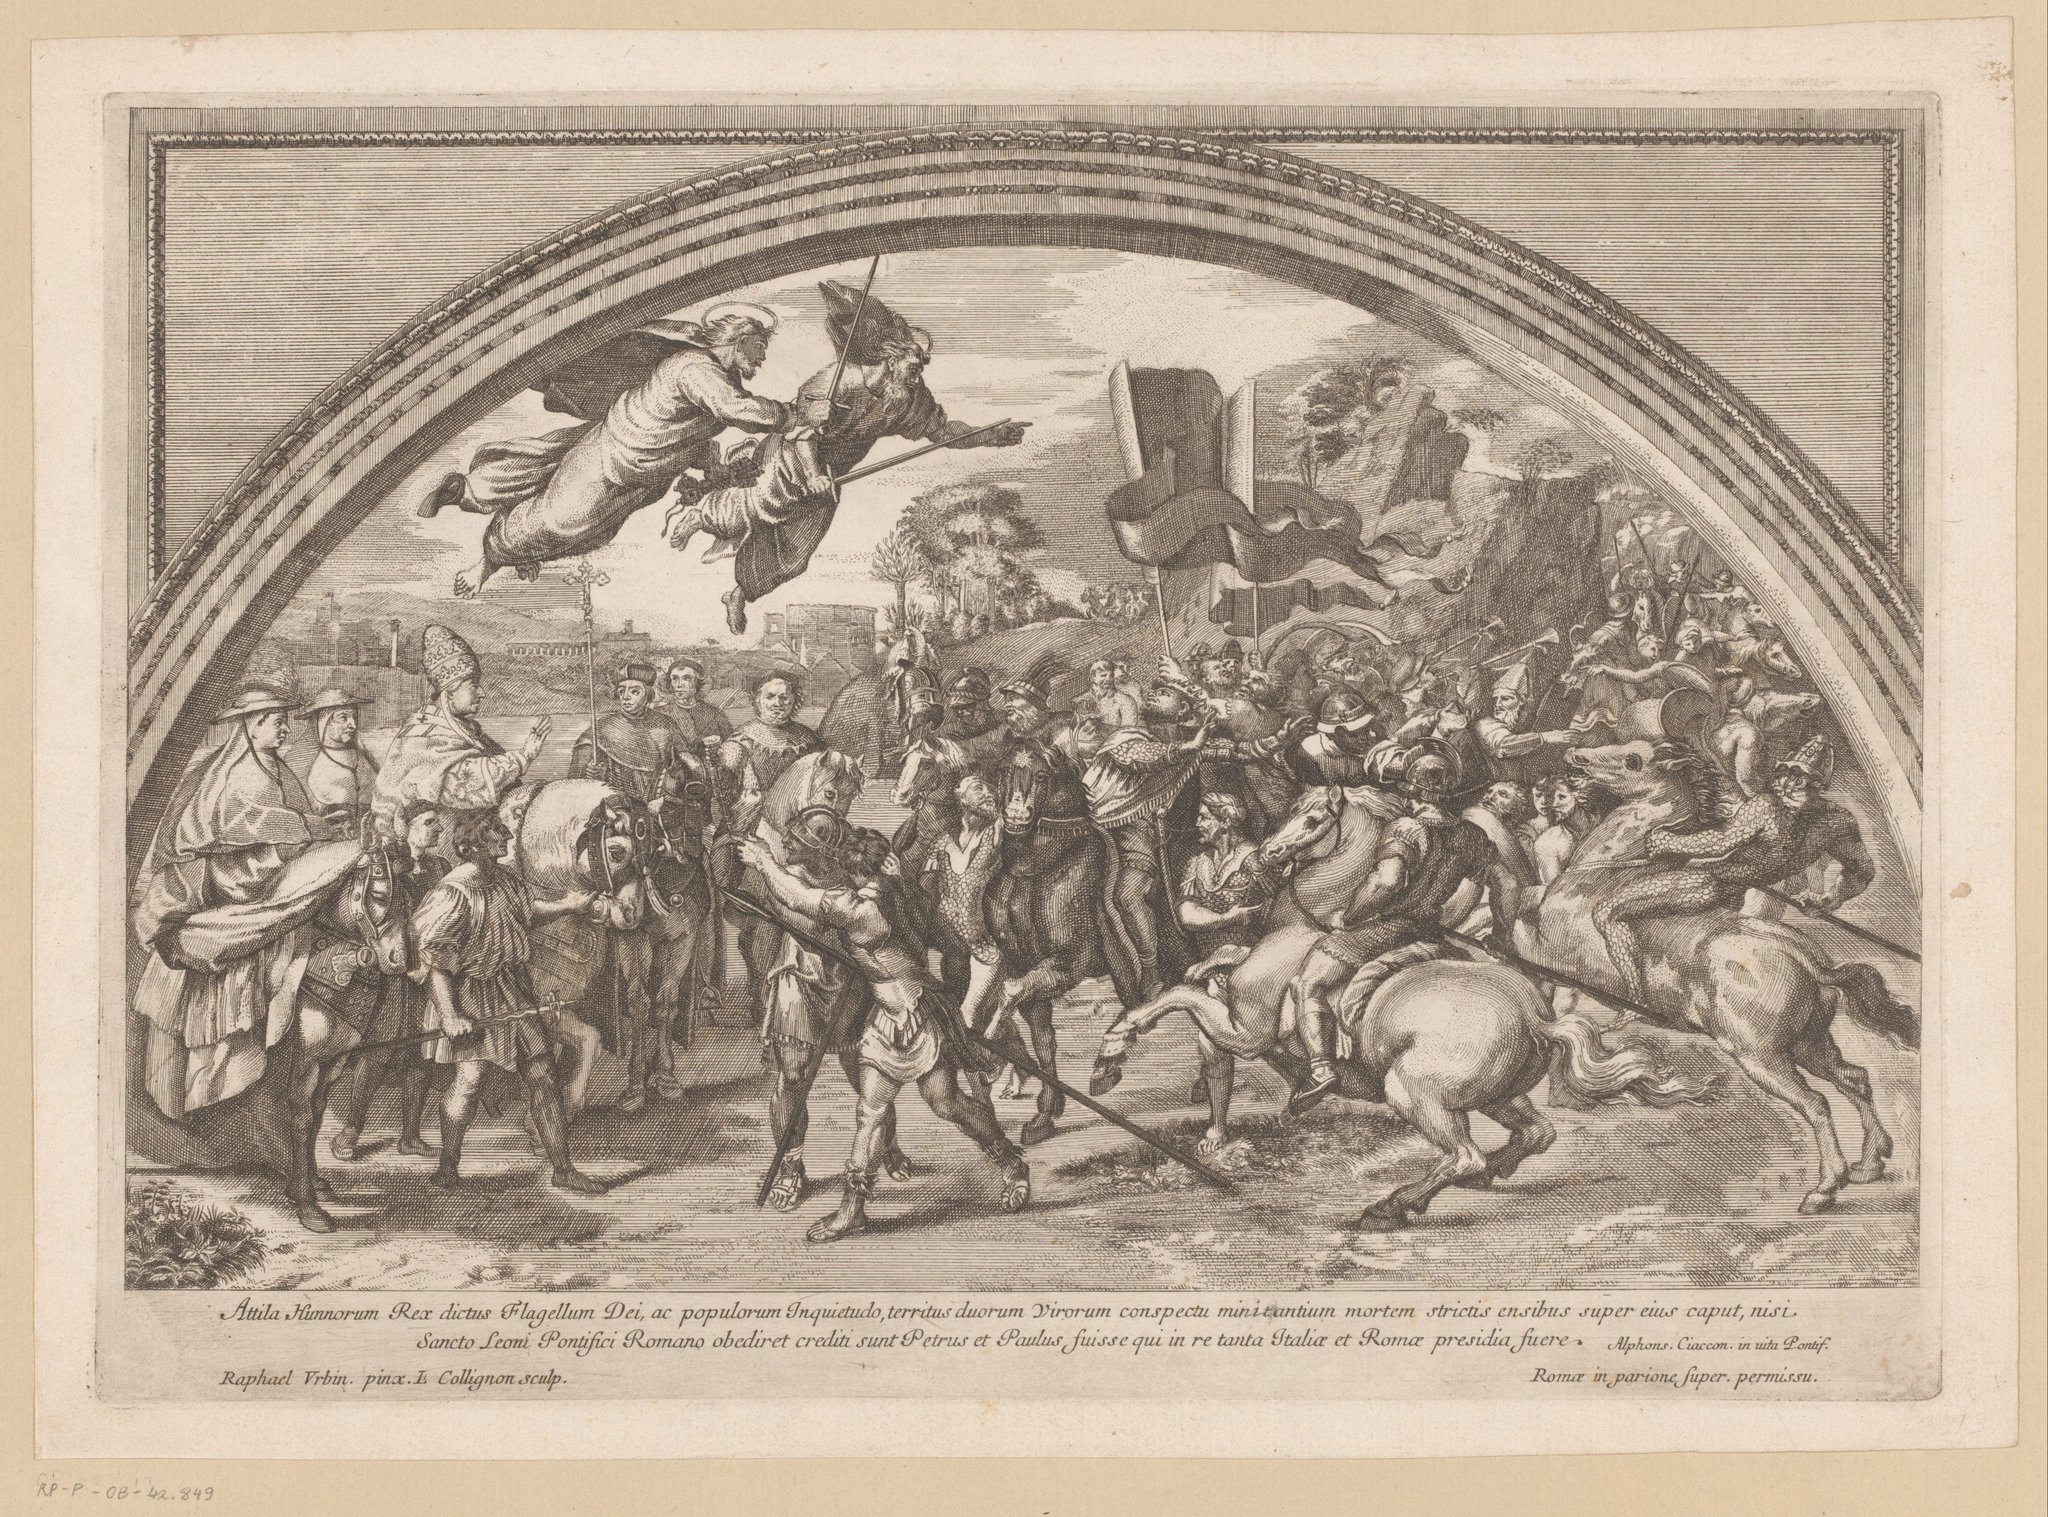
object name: print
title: Ontmoeting tussen paus Leo I de Grote en Attila de Hun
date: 1620-1687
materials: paper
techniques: engraving, etching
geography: vatican city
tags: rome, riding a horse, ass, or mule; rider, horseman, life and acts of peter, meeting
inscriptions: collector's mark: Lugt 240